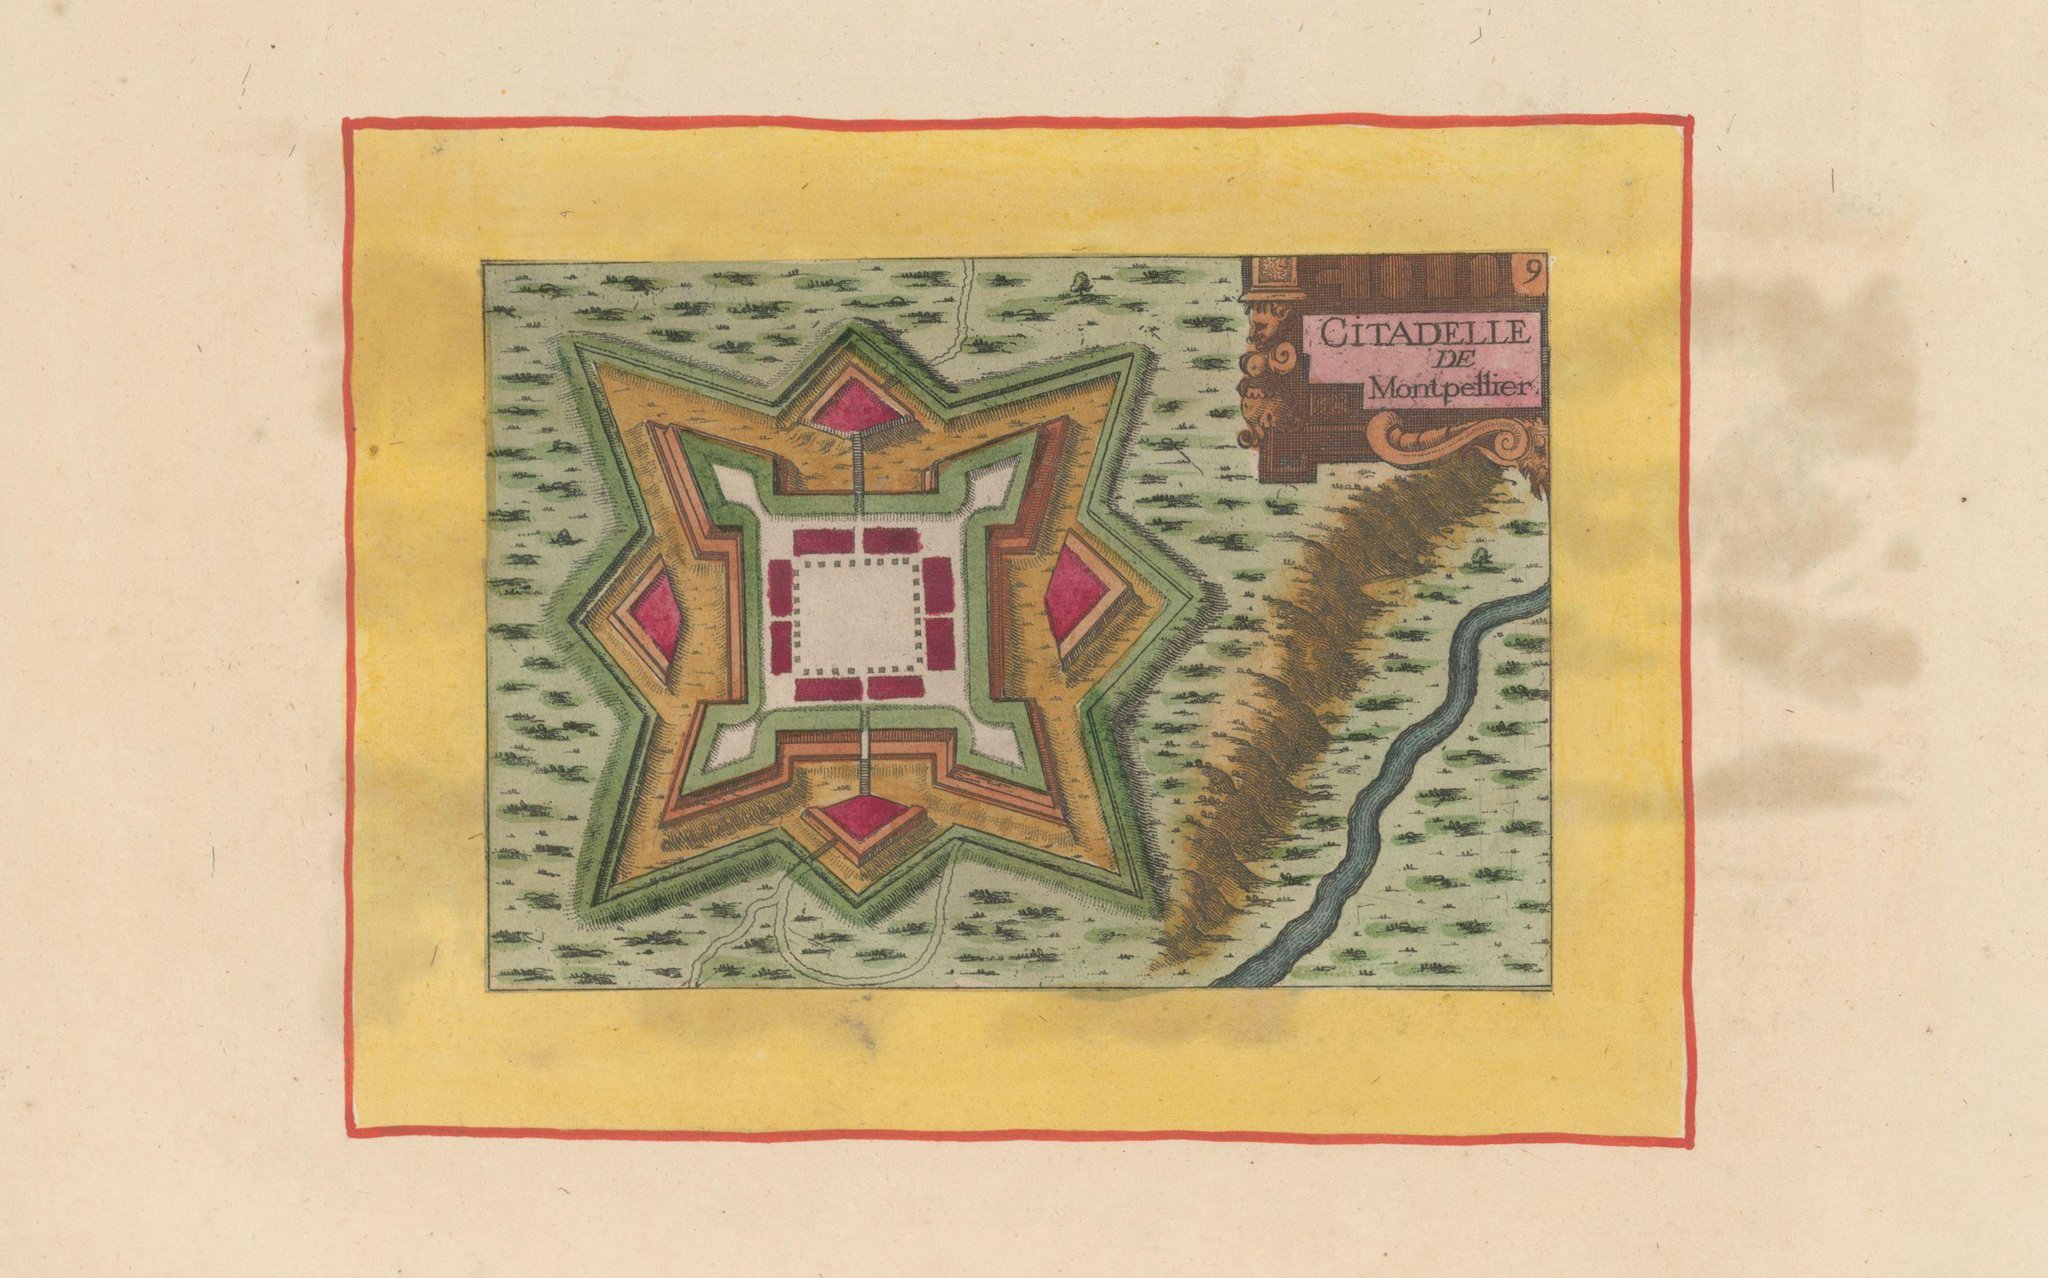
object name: area plan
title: Plattegrond van de vesting bij Montpellier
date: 1638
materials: paper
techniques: engraving, etching, hand coloring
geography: the hague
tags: maps of cities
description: Prent uit: Tassin, Christophe. Les plans et profils de toutes les principales villes et lieux considérables de France (...). Parijs: Michel van Lochom, 1638, prent nummer 9 in het deel 'Languedoc'.